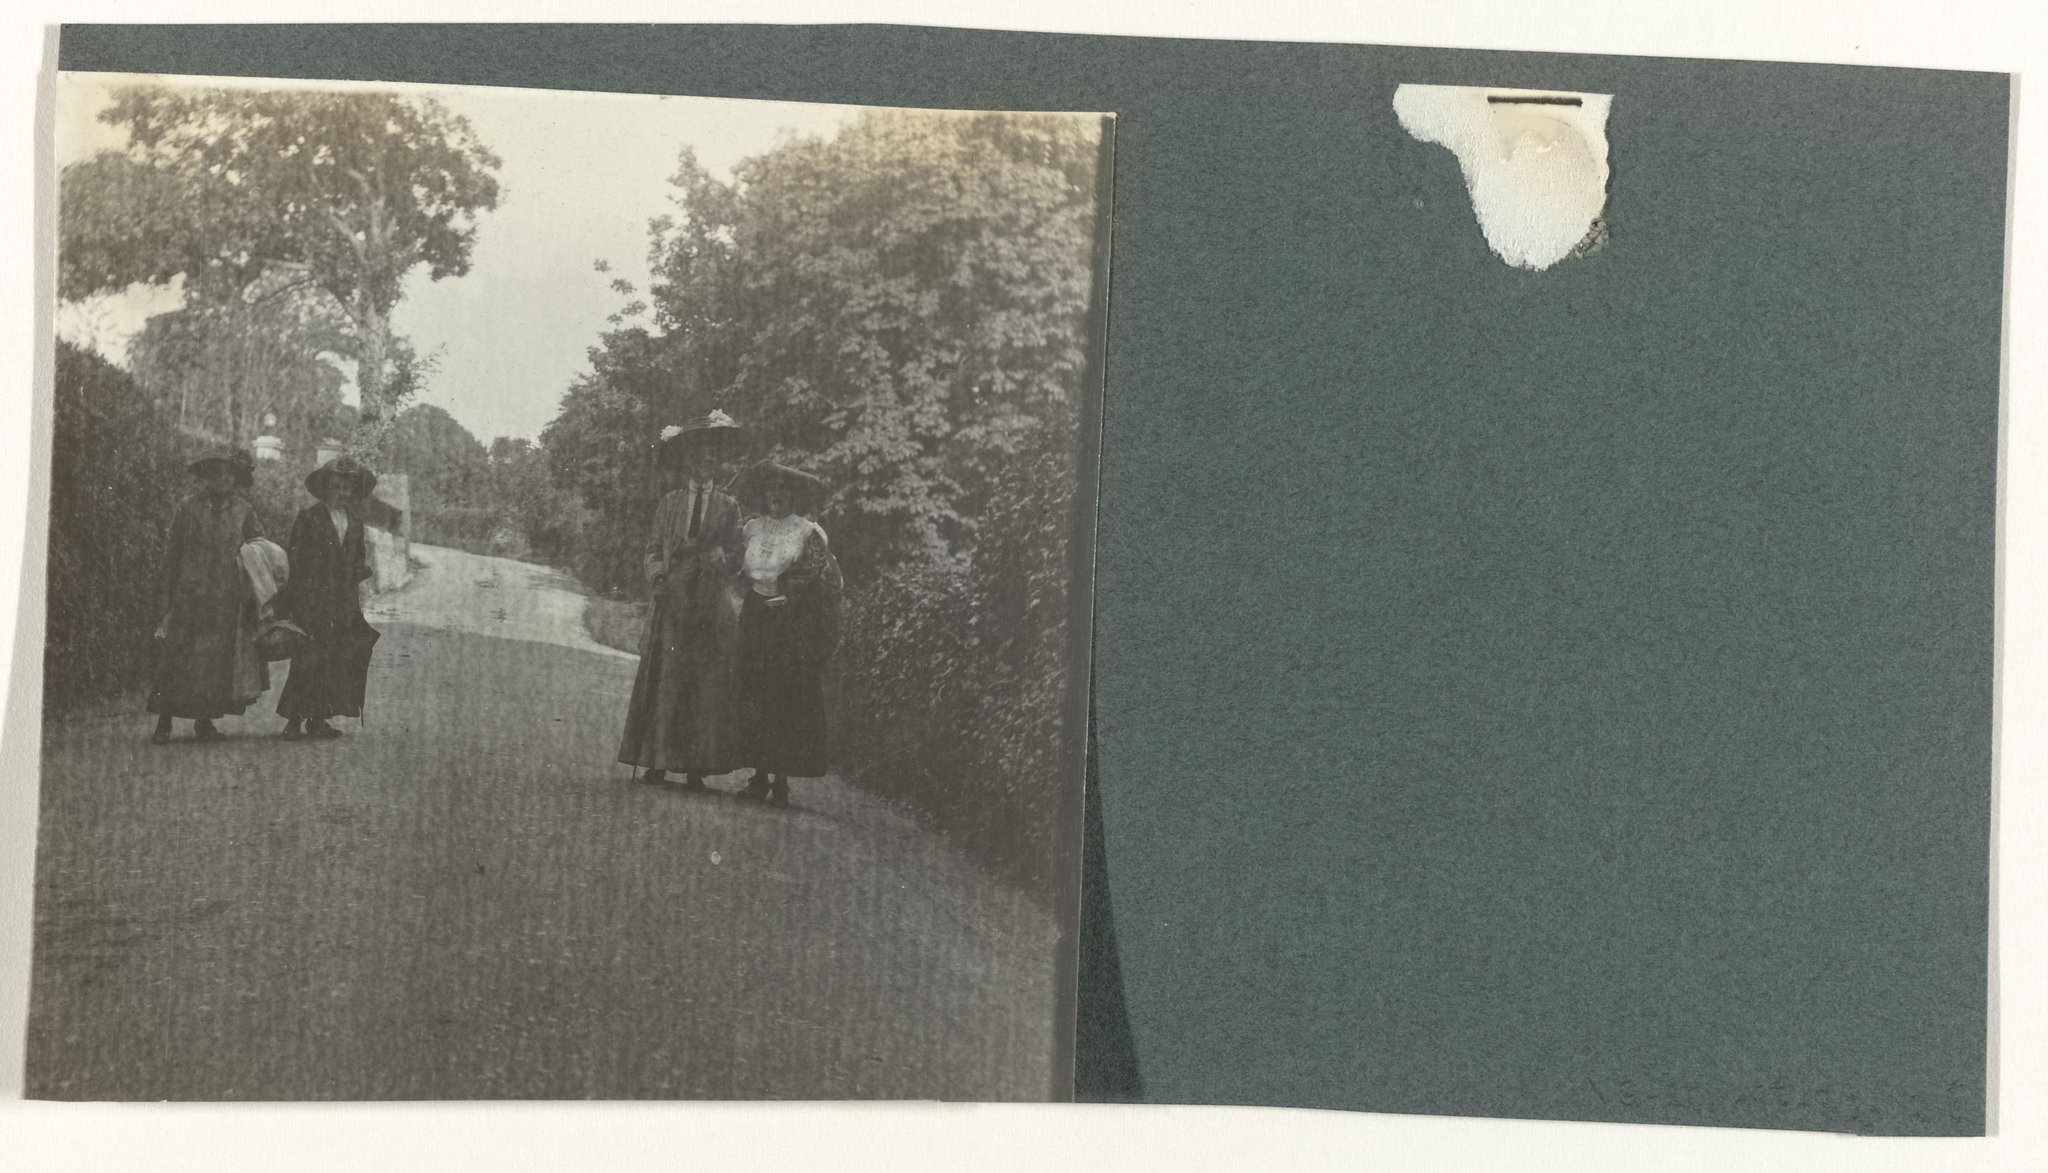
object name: photograph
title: Vier onbekende vrouwen, Bexhill-on-Sea in Engeland, 1913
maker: Anonymous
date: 1913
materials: photographic support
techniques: gelatin silver print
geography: bexhill-on-sea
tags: england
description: Vier onbekende vrouwen, Bexhill-on-Sea in Engeland.